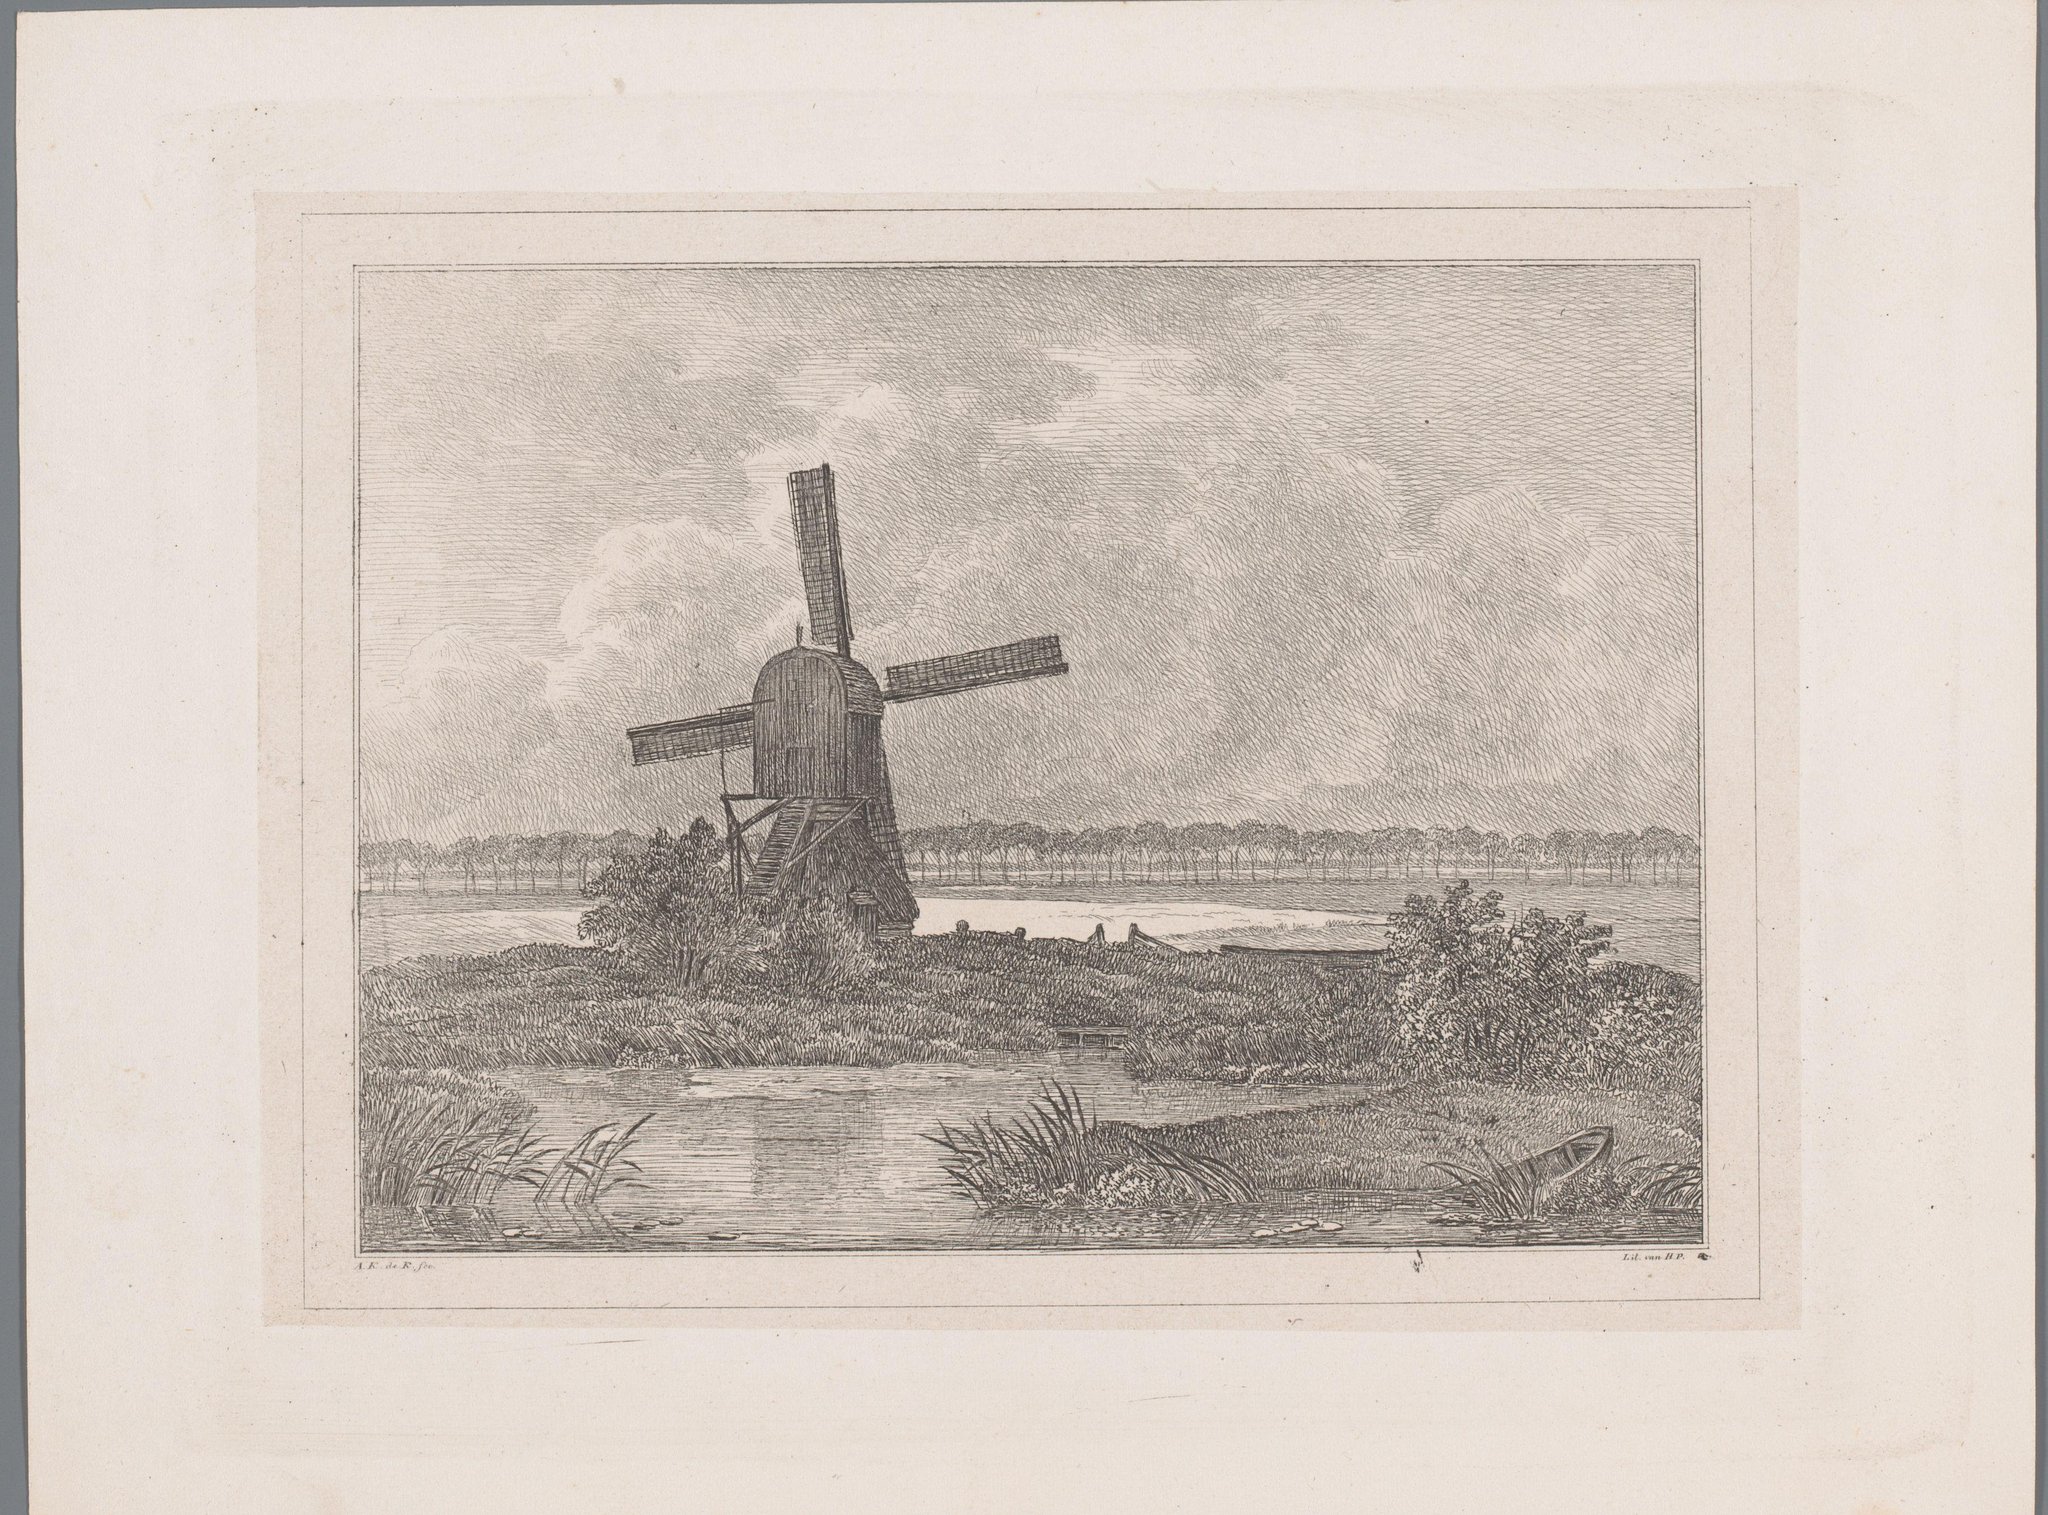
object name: print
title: Zestal gezigten in de omstreken van Dordrecht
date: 1839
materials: paper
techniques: etching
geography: dordrecht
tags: windmill in landscape, dordrecht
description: De molen staat aan het water. Rechts ligt een half gezonken boot.